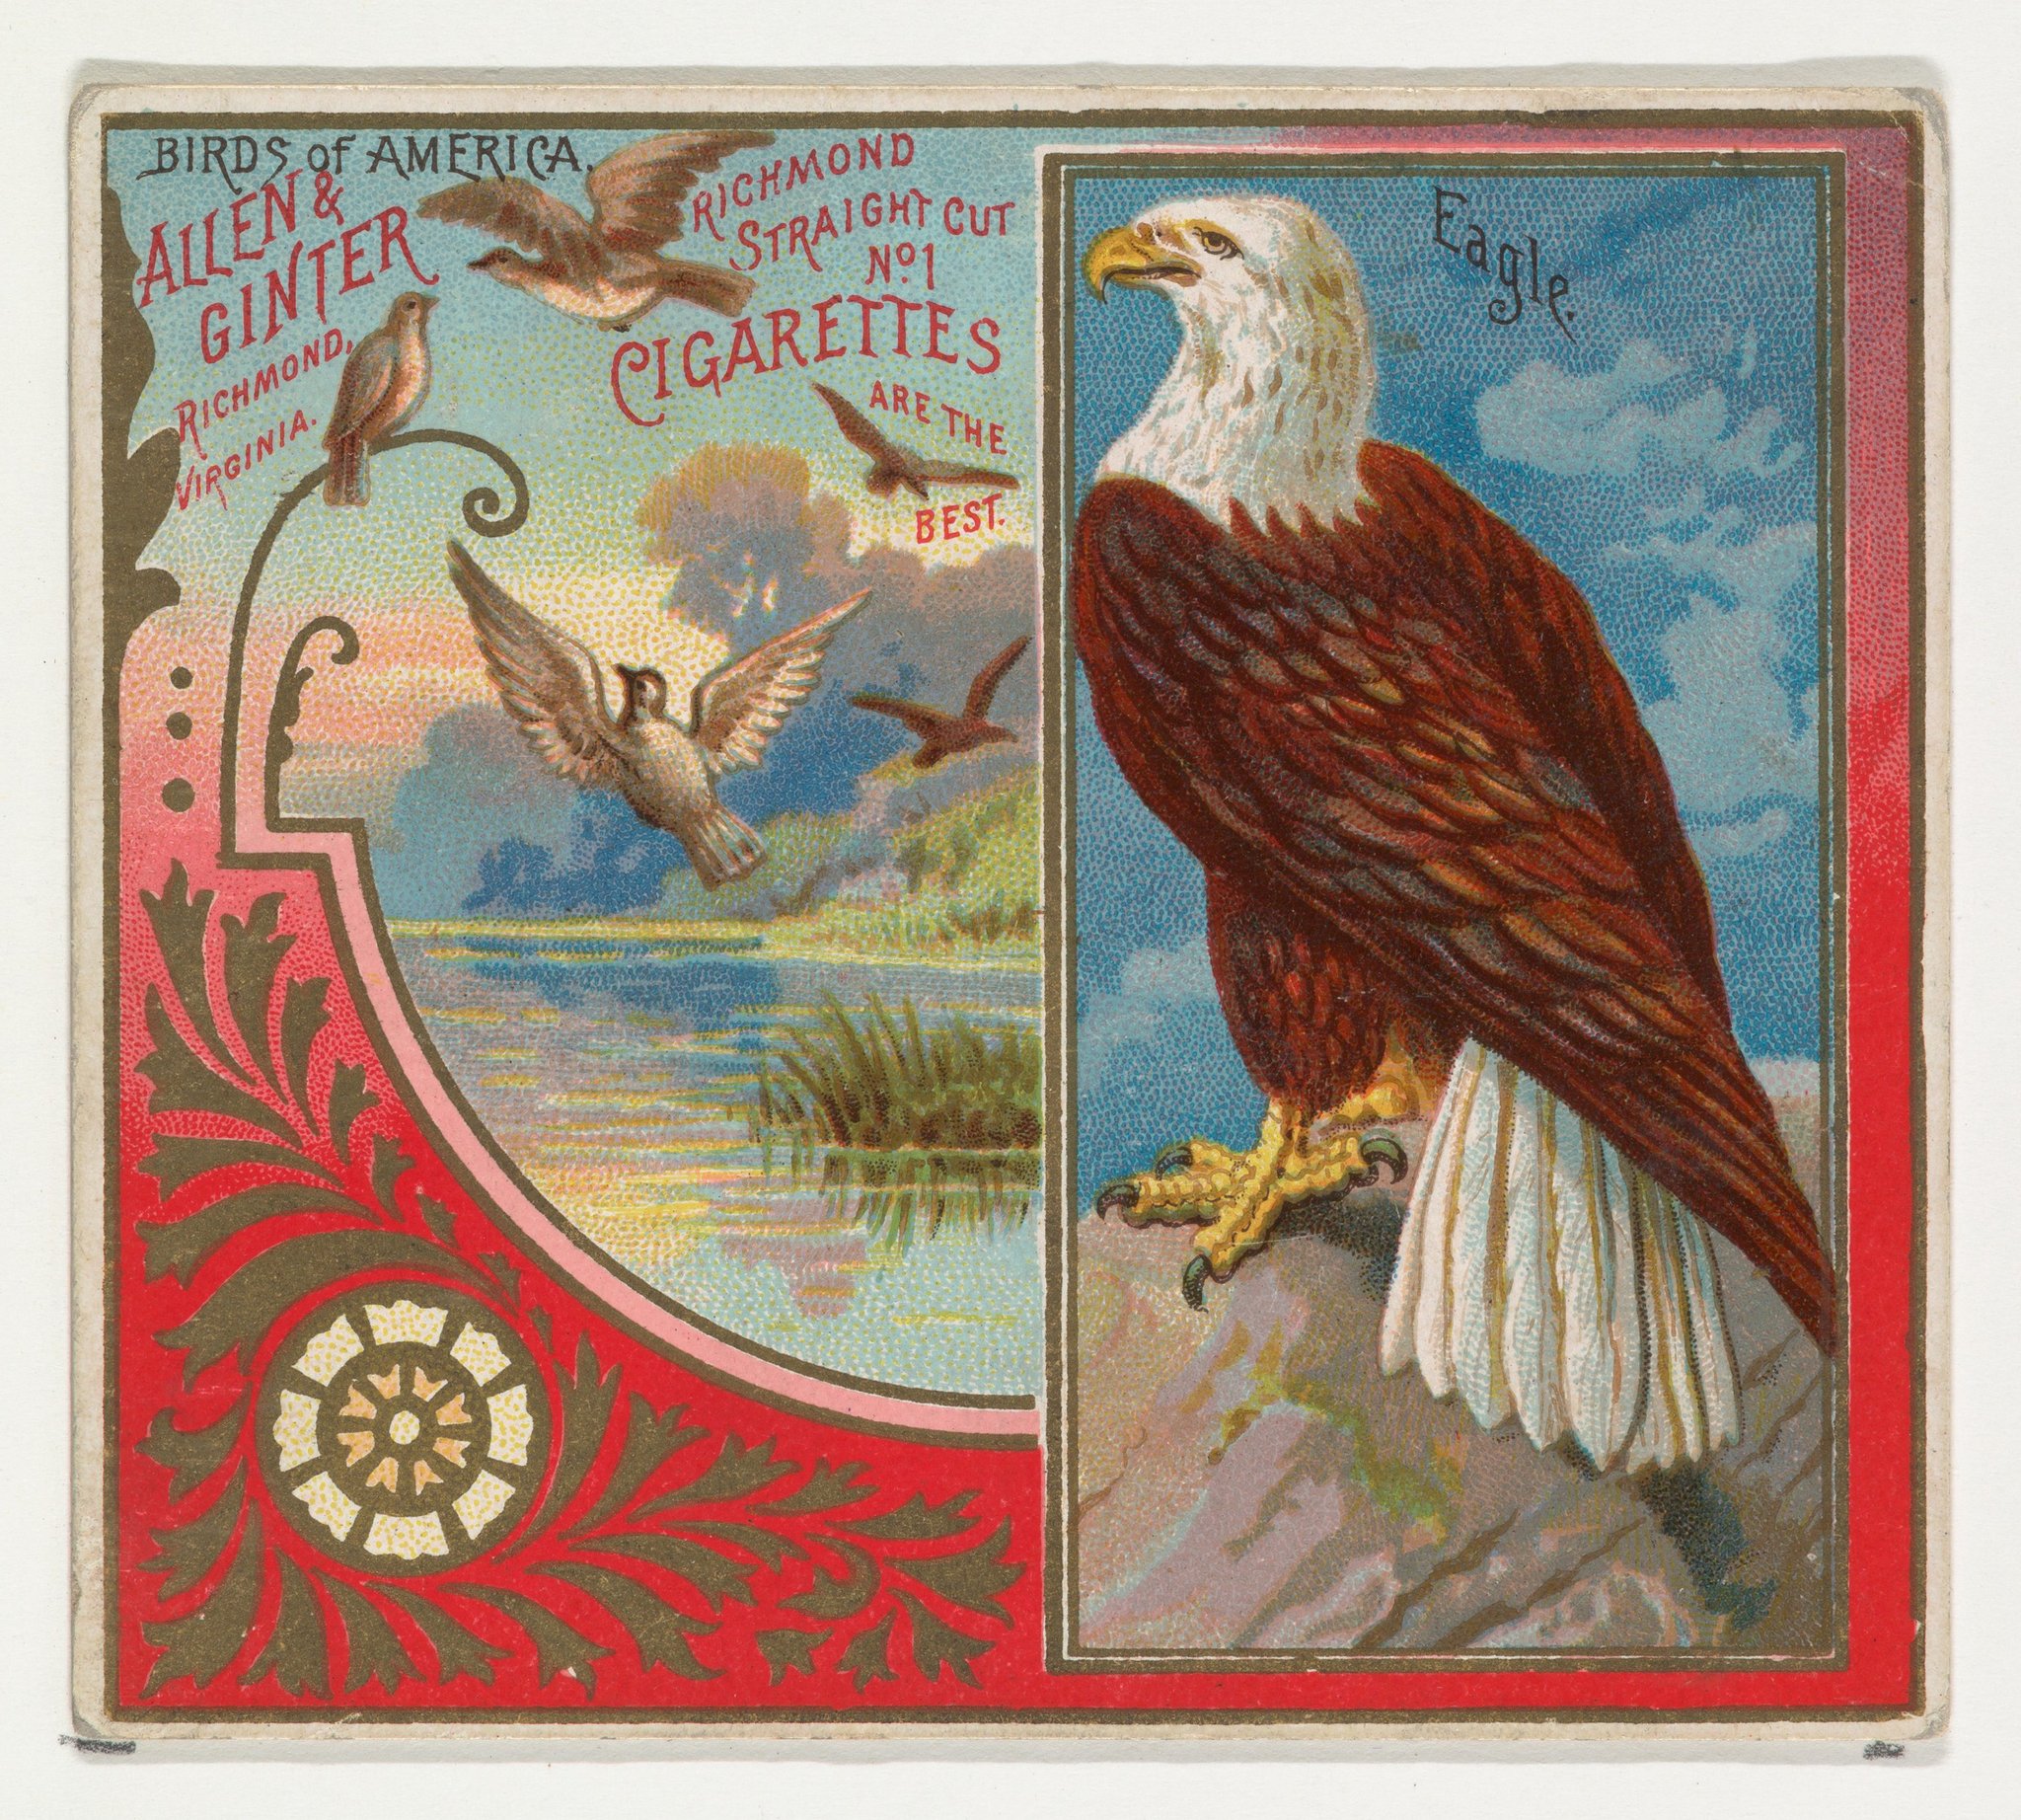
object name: print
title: Eagle, from the Birds of America series (N37) for Allen & Ginter Cigarettes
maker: allen & ginter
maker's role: publisher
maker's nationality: american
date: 1888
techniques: color lithograph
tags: eagles